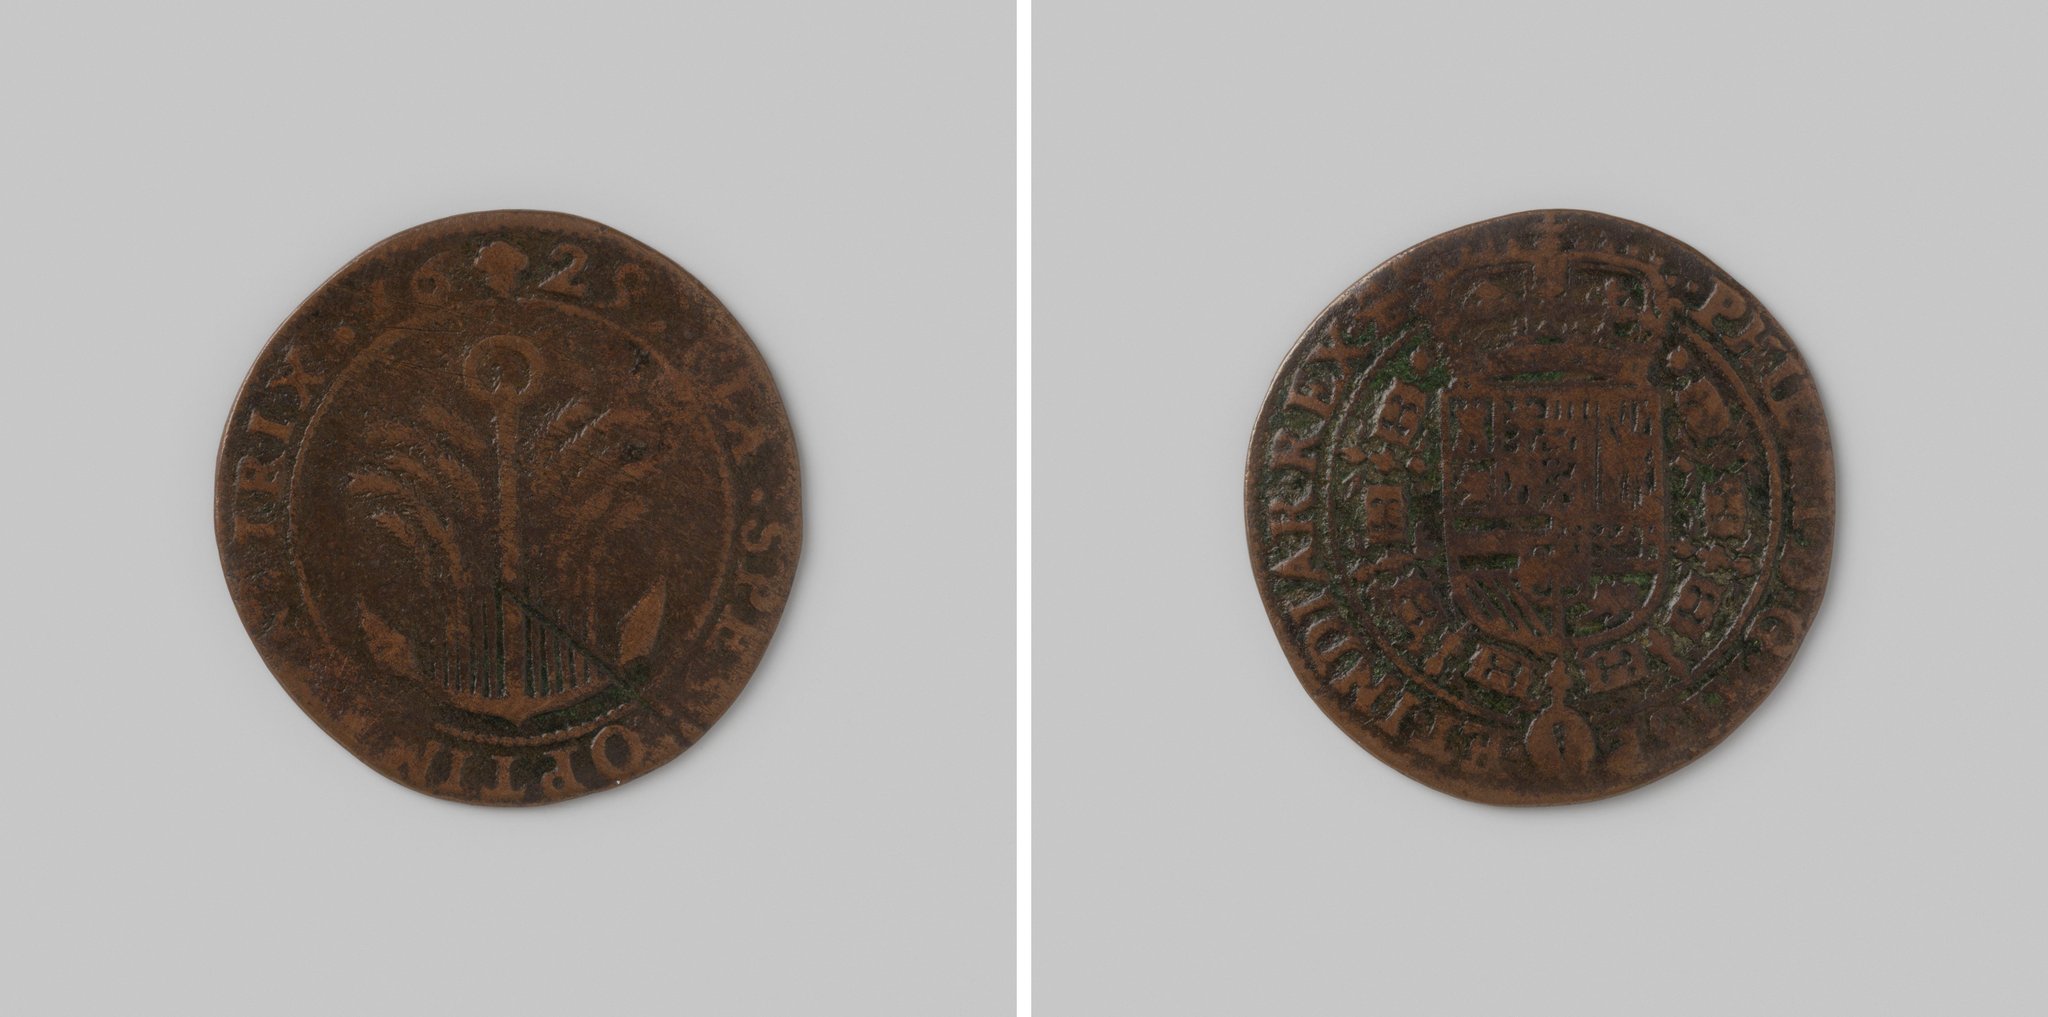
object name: history medal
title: Rekenpenning uit Brussel op het vertrouwen van de Spanjaarden 1629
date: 1629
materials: copper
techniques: striking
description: Koperen penning, op de voorzijde een anker met korenaren, met omschrift, op de keerzijde het gekroonde Spaanse wapenschild omhangen met de keten van het Gulden Vlies, met omschrift.